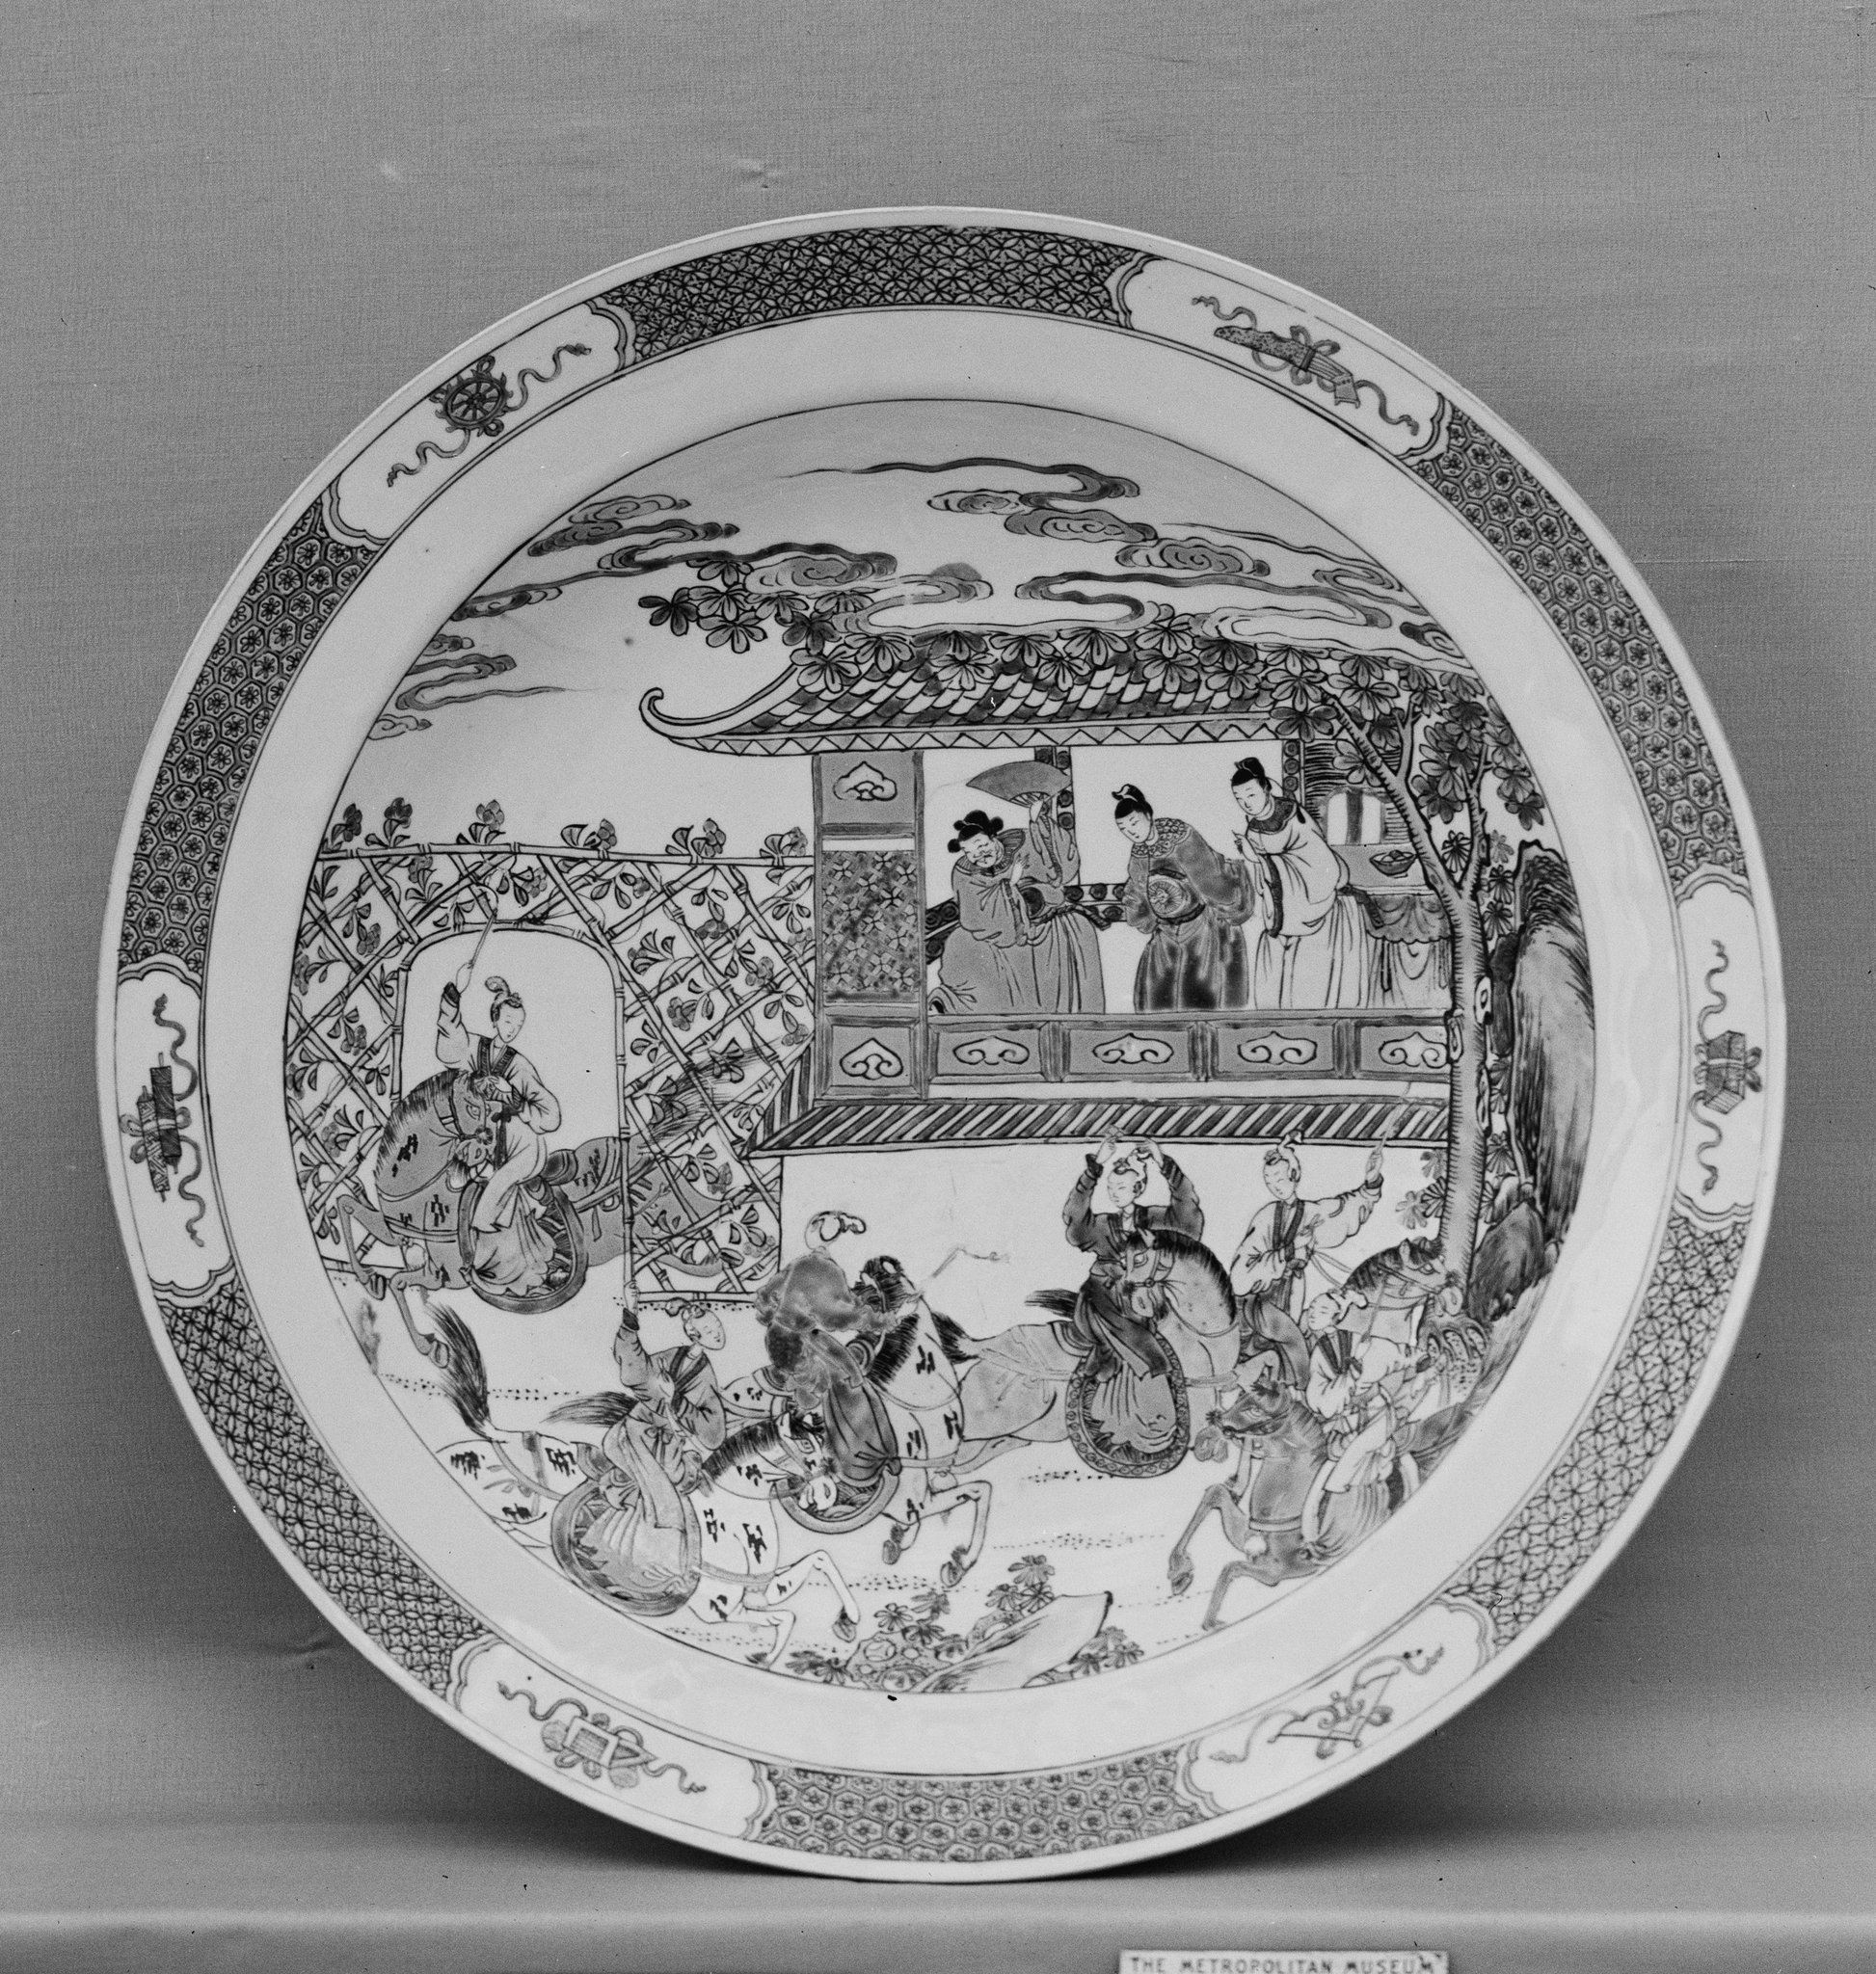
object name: plate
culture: chinese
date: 1767-1900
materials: enamel, porcelain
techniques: overglaze, painting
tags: men,women,horses